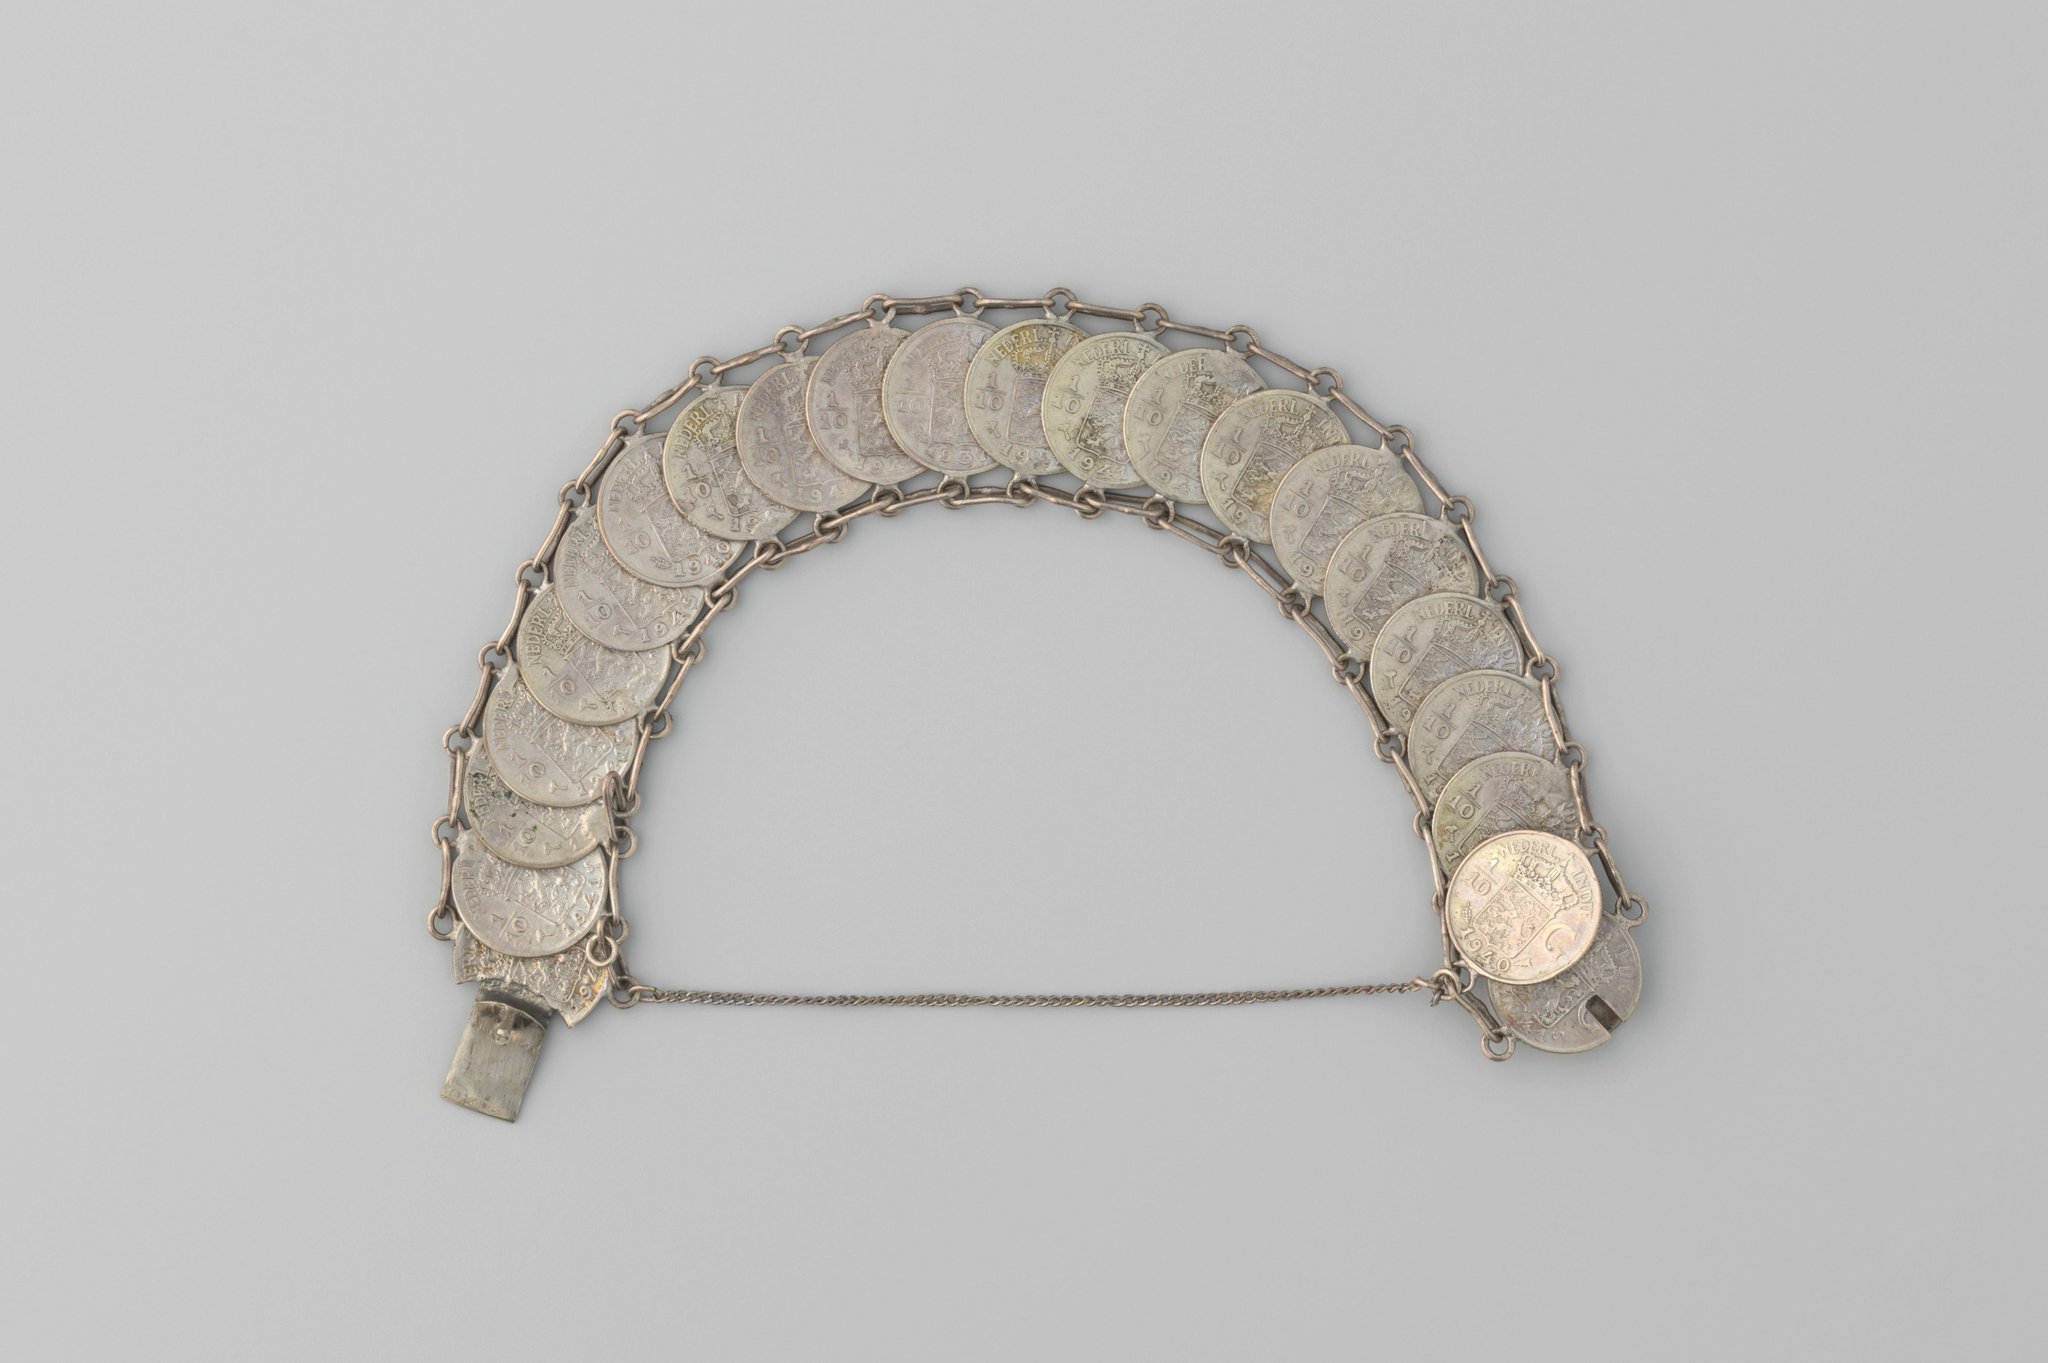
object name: bracelet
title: Zilveren armband van tweeëntwintig geschakelde Nederlands-Indische dubbeltjes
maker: Anonymous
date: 1940-1950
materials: silver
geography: netherlands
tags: dutch east indies, the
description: Zilveren armband van tweeëntwintig geschakelde Nederlands-Indische dubbeltjes (inclusief de munten in de baksluiting), voorzien van een baksluiting en een gourmetveiligheidsketting. De armband is niet gekeurd.